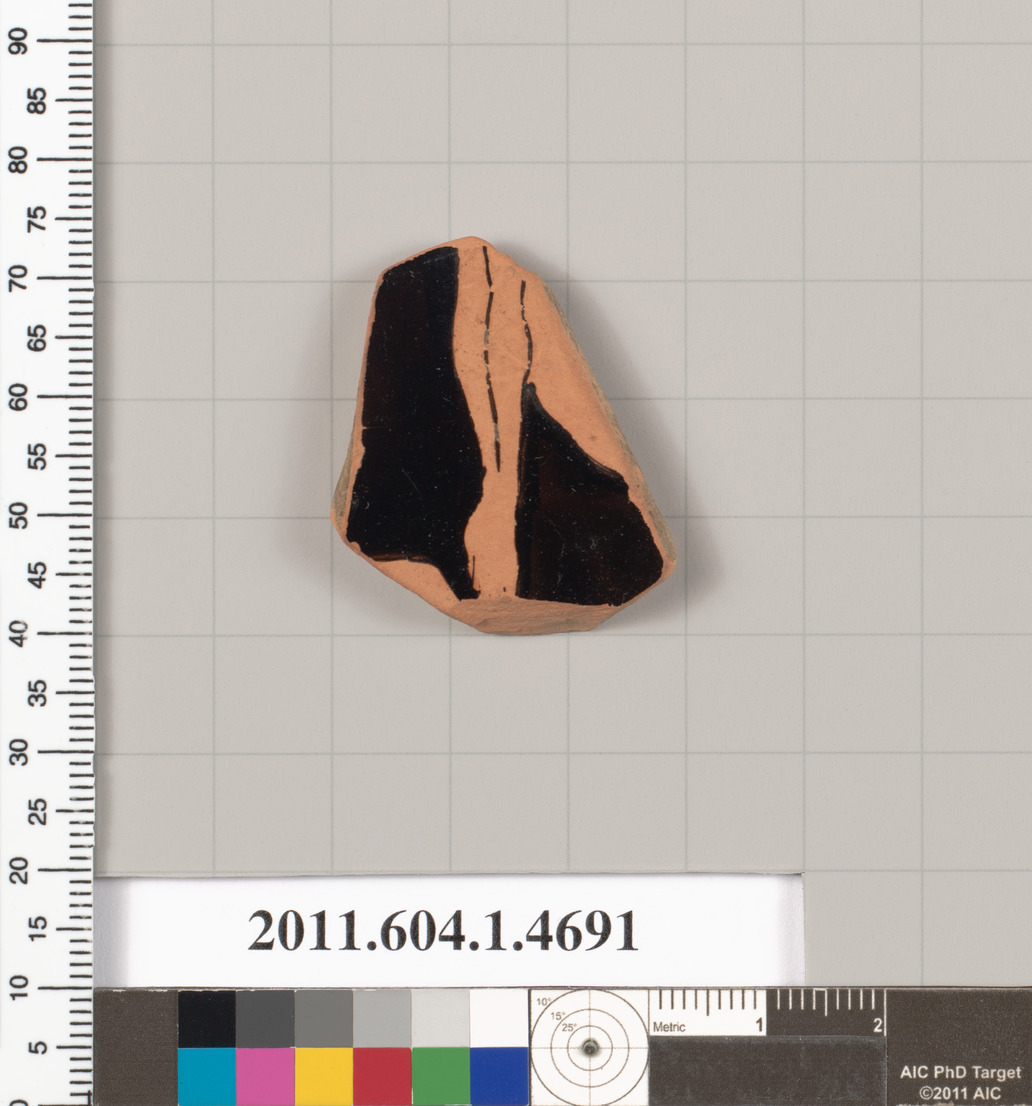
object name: kylix fragment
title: Terracotta fragment of a kylix (drinking cup)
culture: greek, attic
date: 490-480 BCE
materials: terracotta